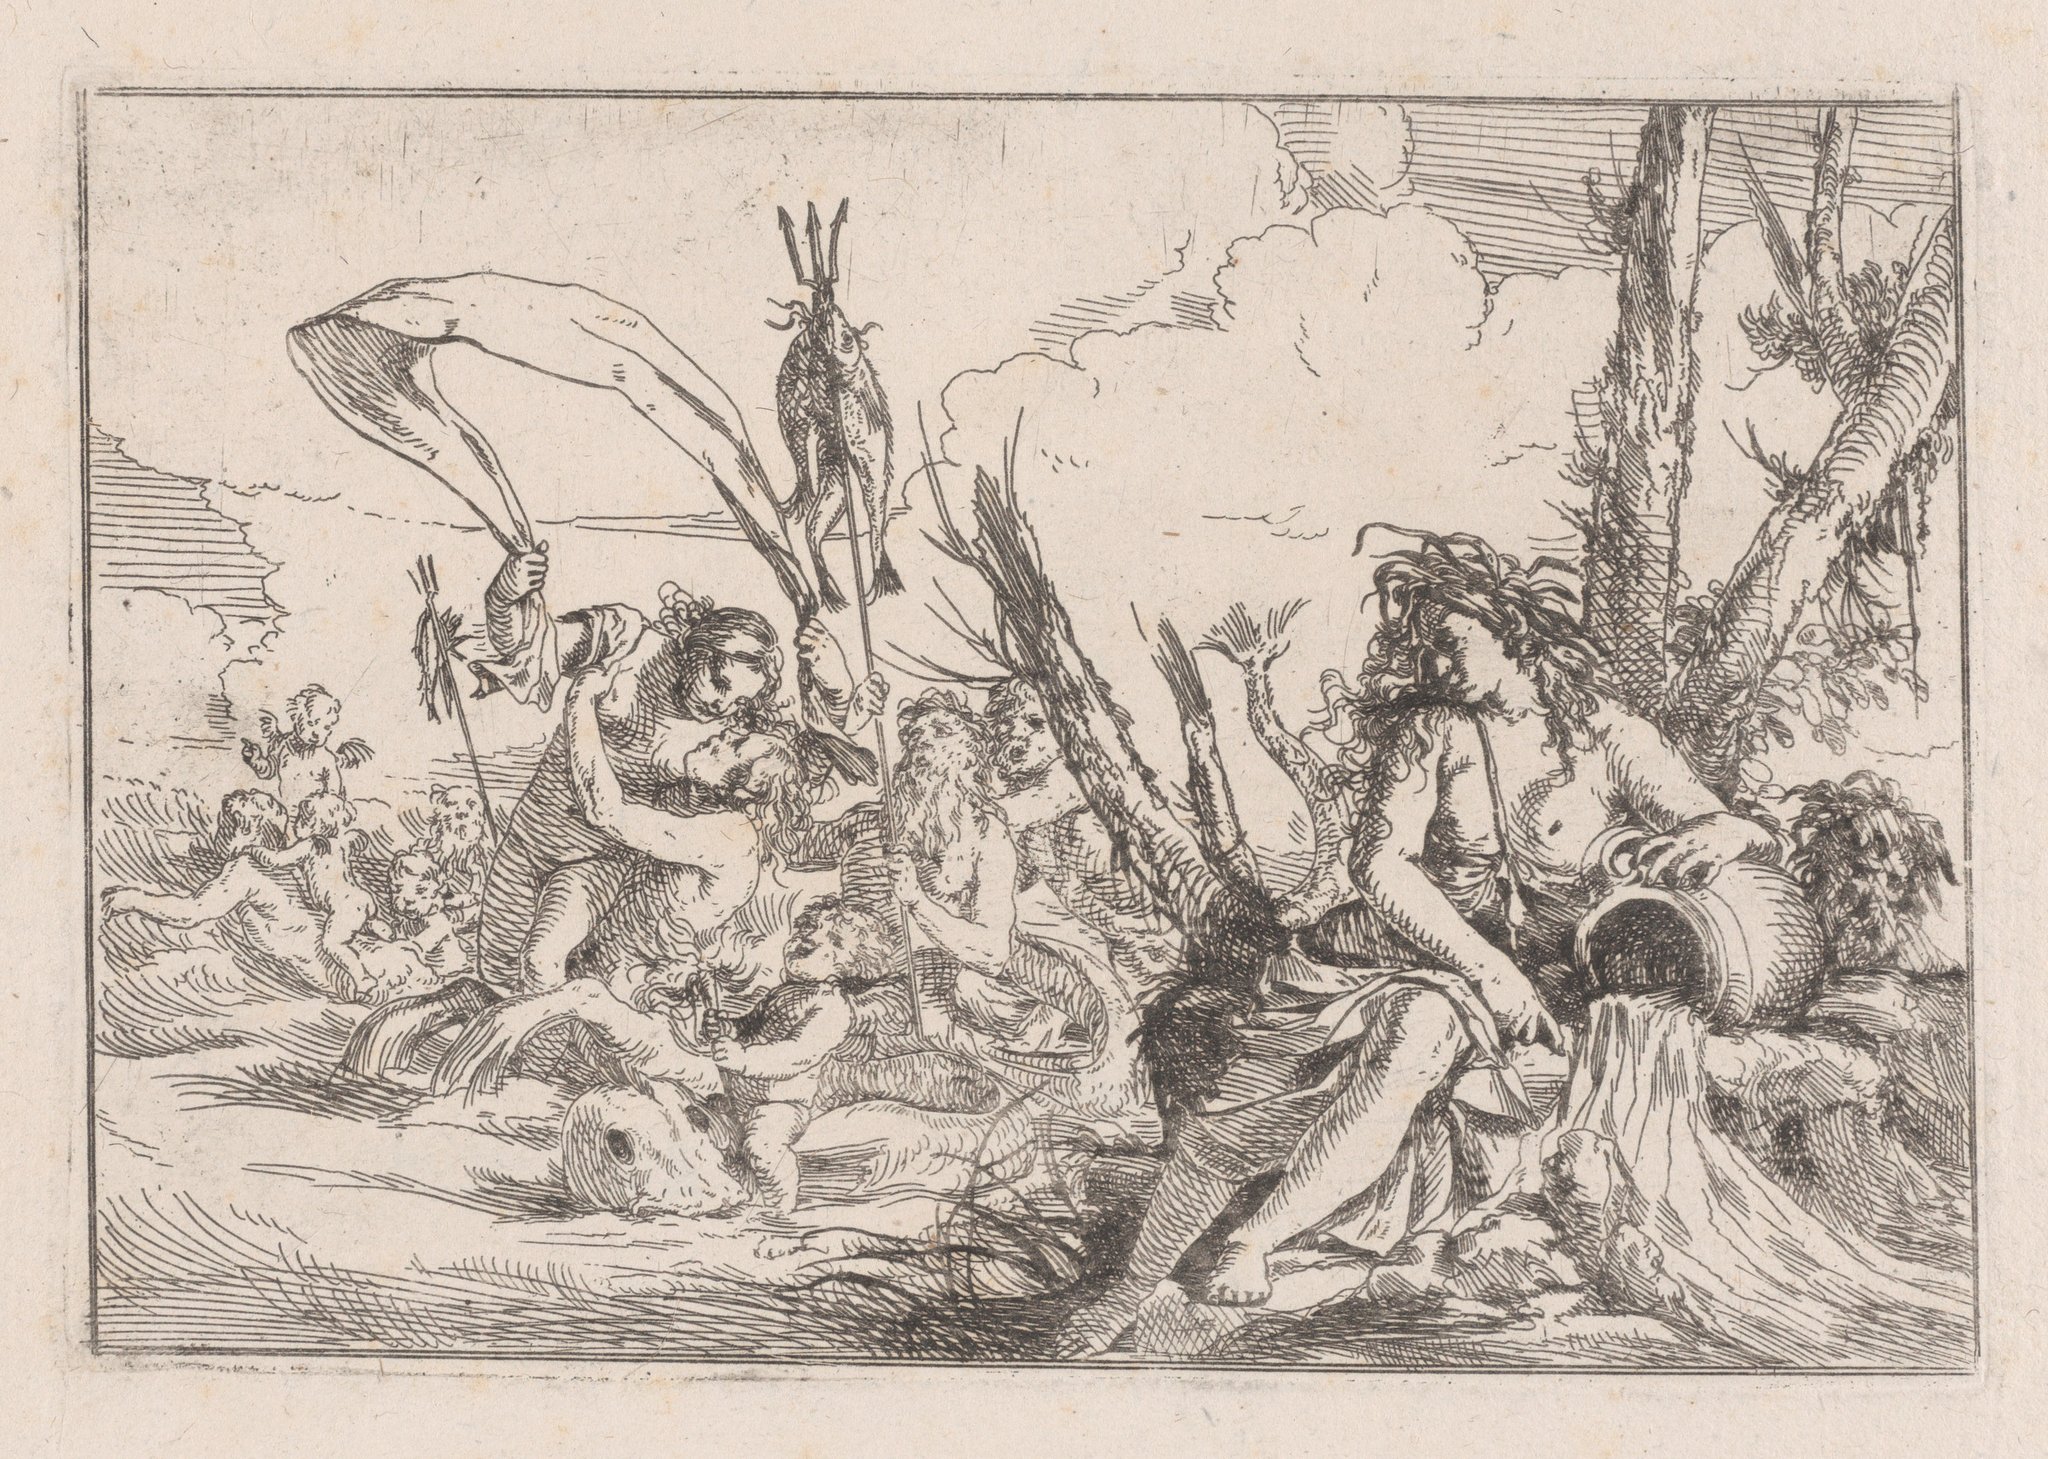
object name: print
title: Water, represented by a naiad seated at the base of a tree and resting her arm on a supine urn from which water flows, behind her a triton and other inhabitants of the sea rise from the water surface, from "The Elements"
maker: giulio carpioni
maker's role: artist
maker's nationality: italian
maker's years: 1613-1678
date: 1640-1660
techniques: etching